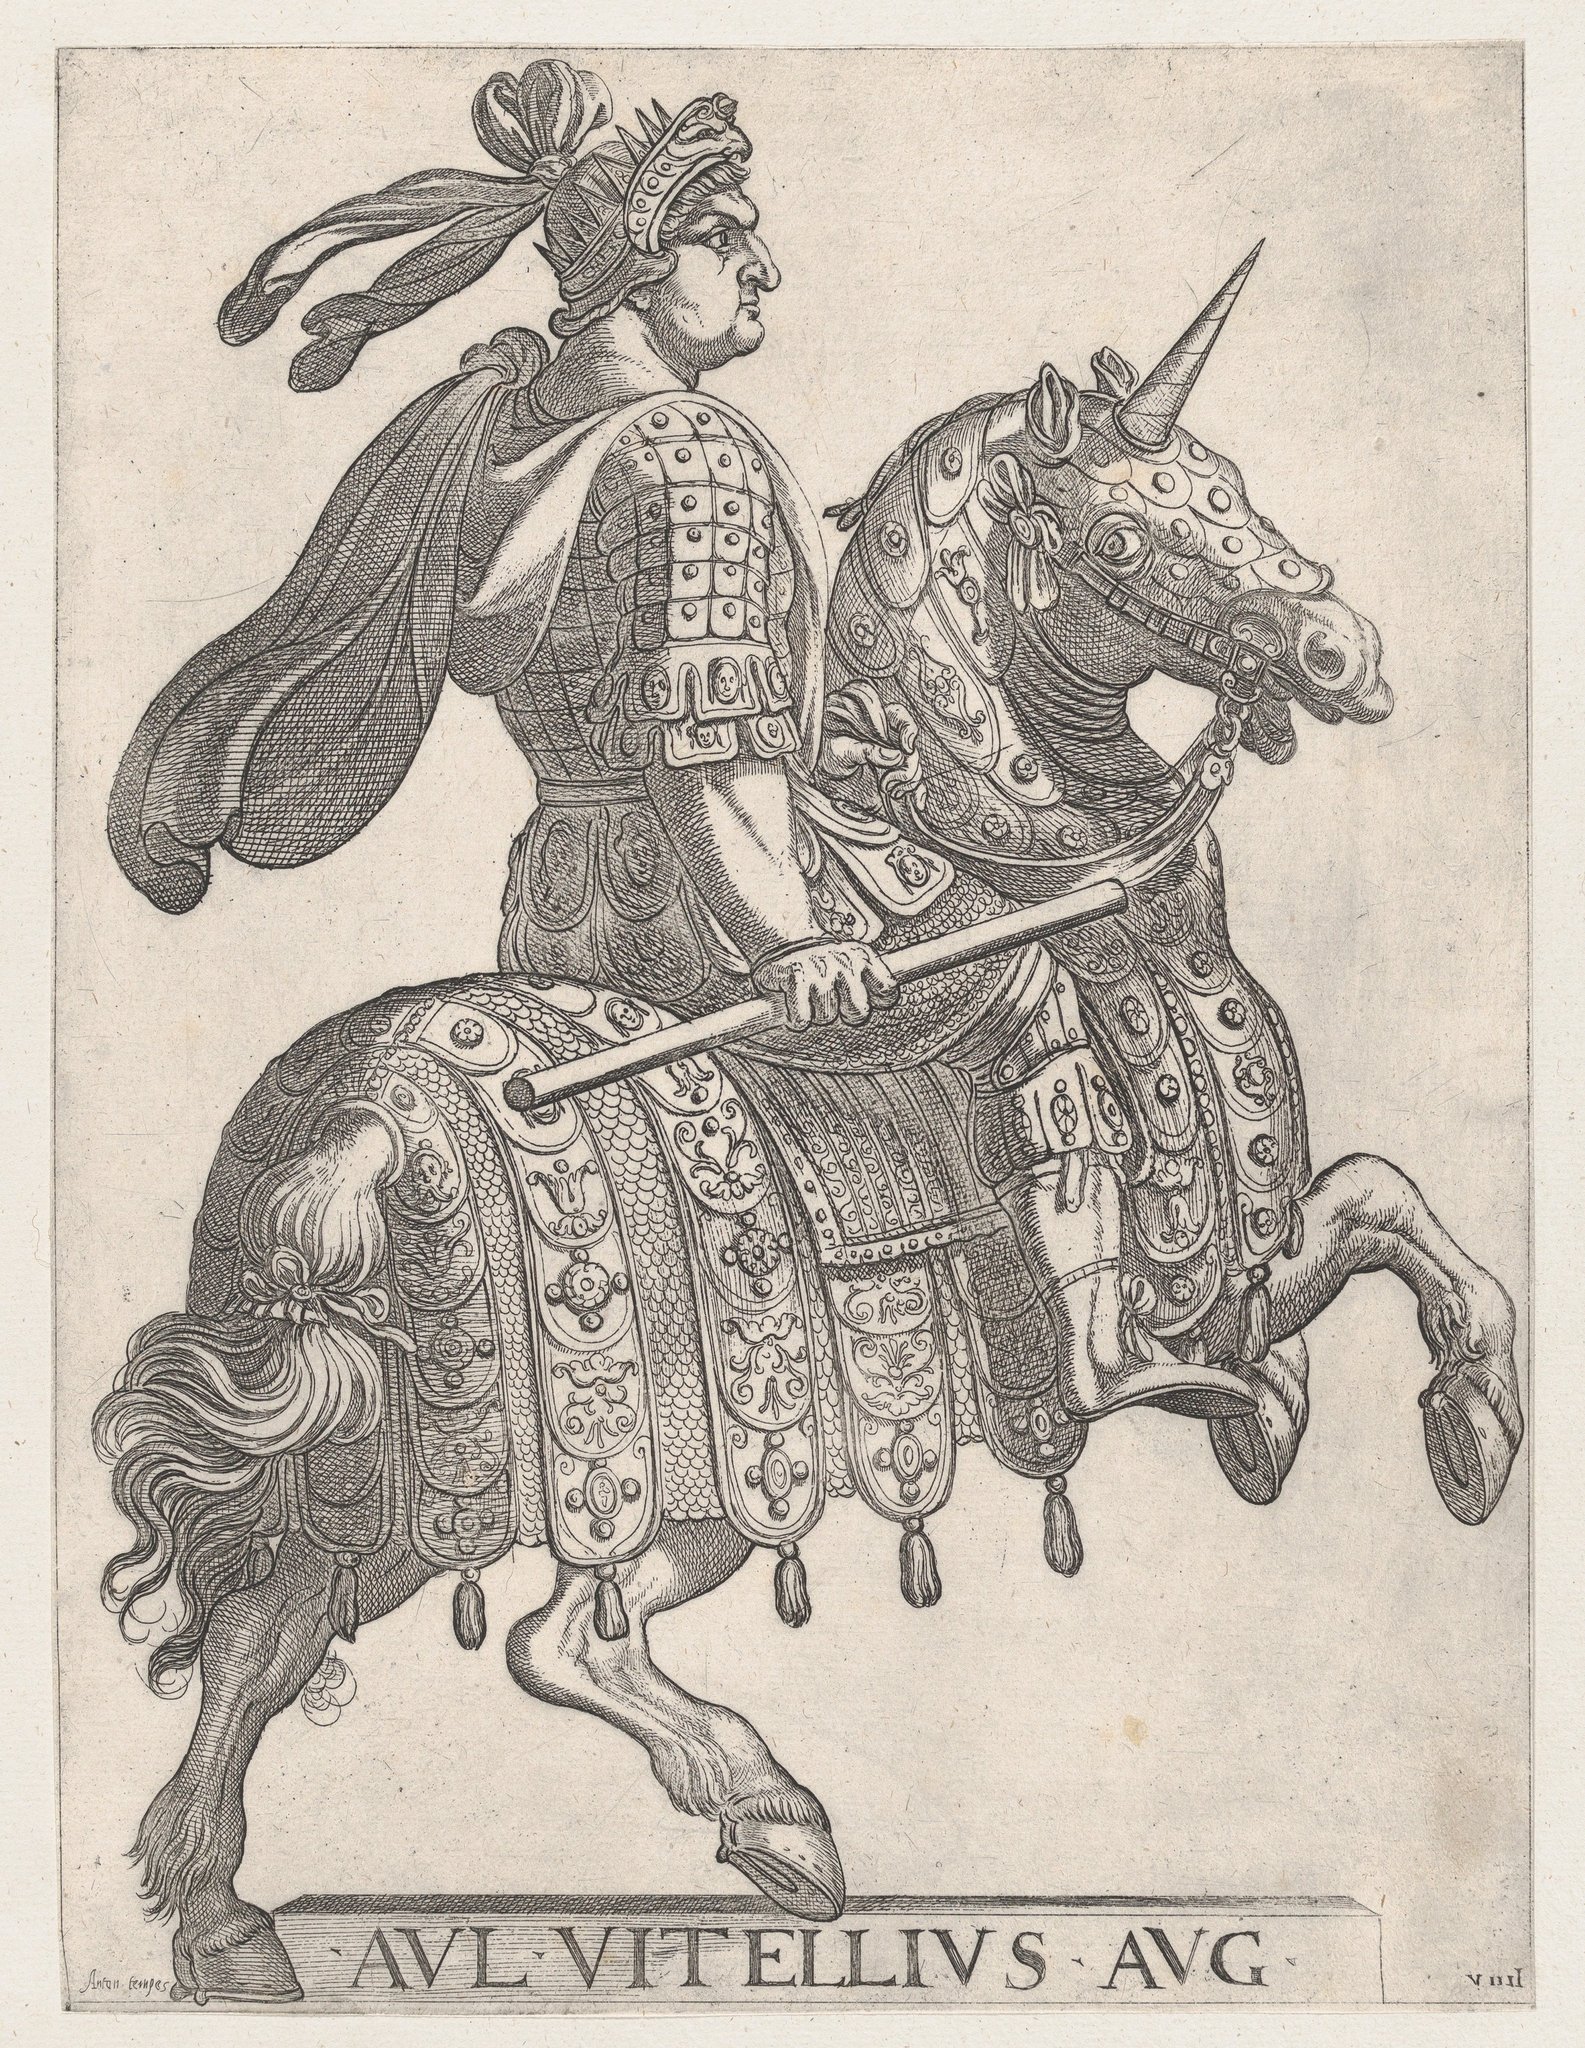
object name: print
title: Plate 9: Emperor Vitellus on Horseback, from 'The First Twelve Roman Caesars'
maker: antonio tempesta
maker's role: artist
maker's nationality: italian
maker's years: 1555-1630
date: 1596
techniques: etching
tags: men,horses